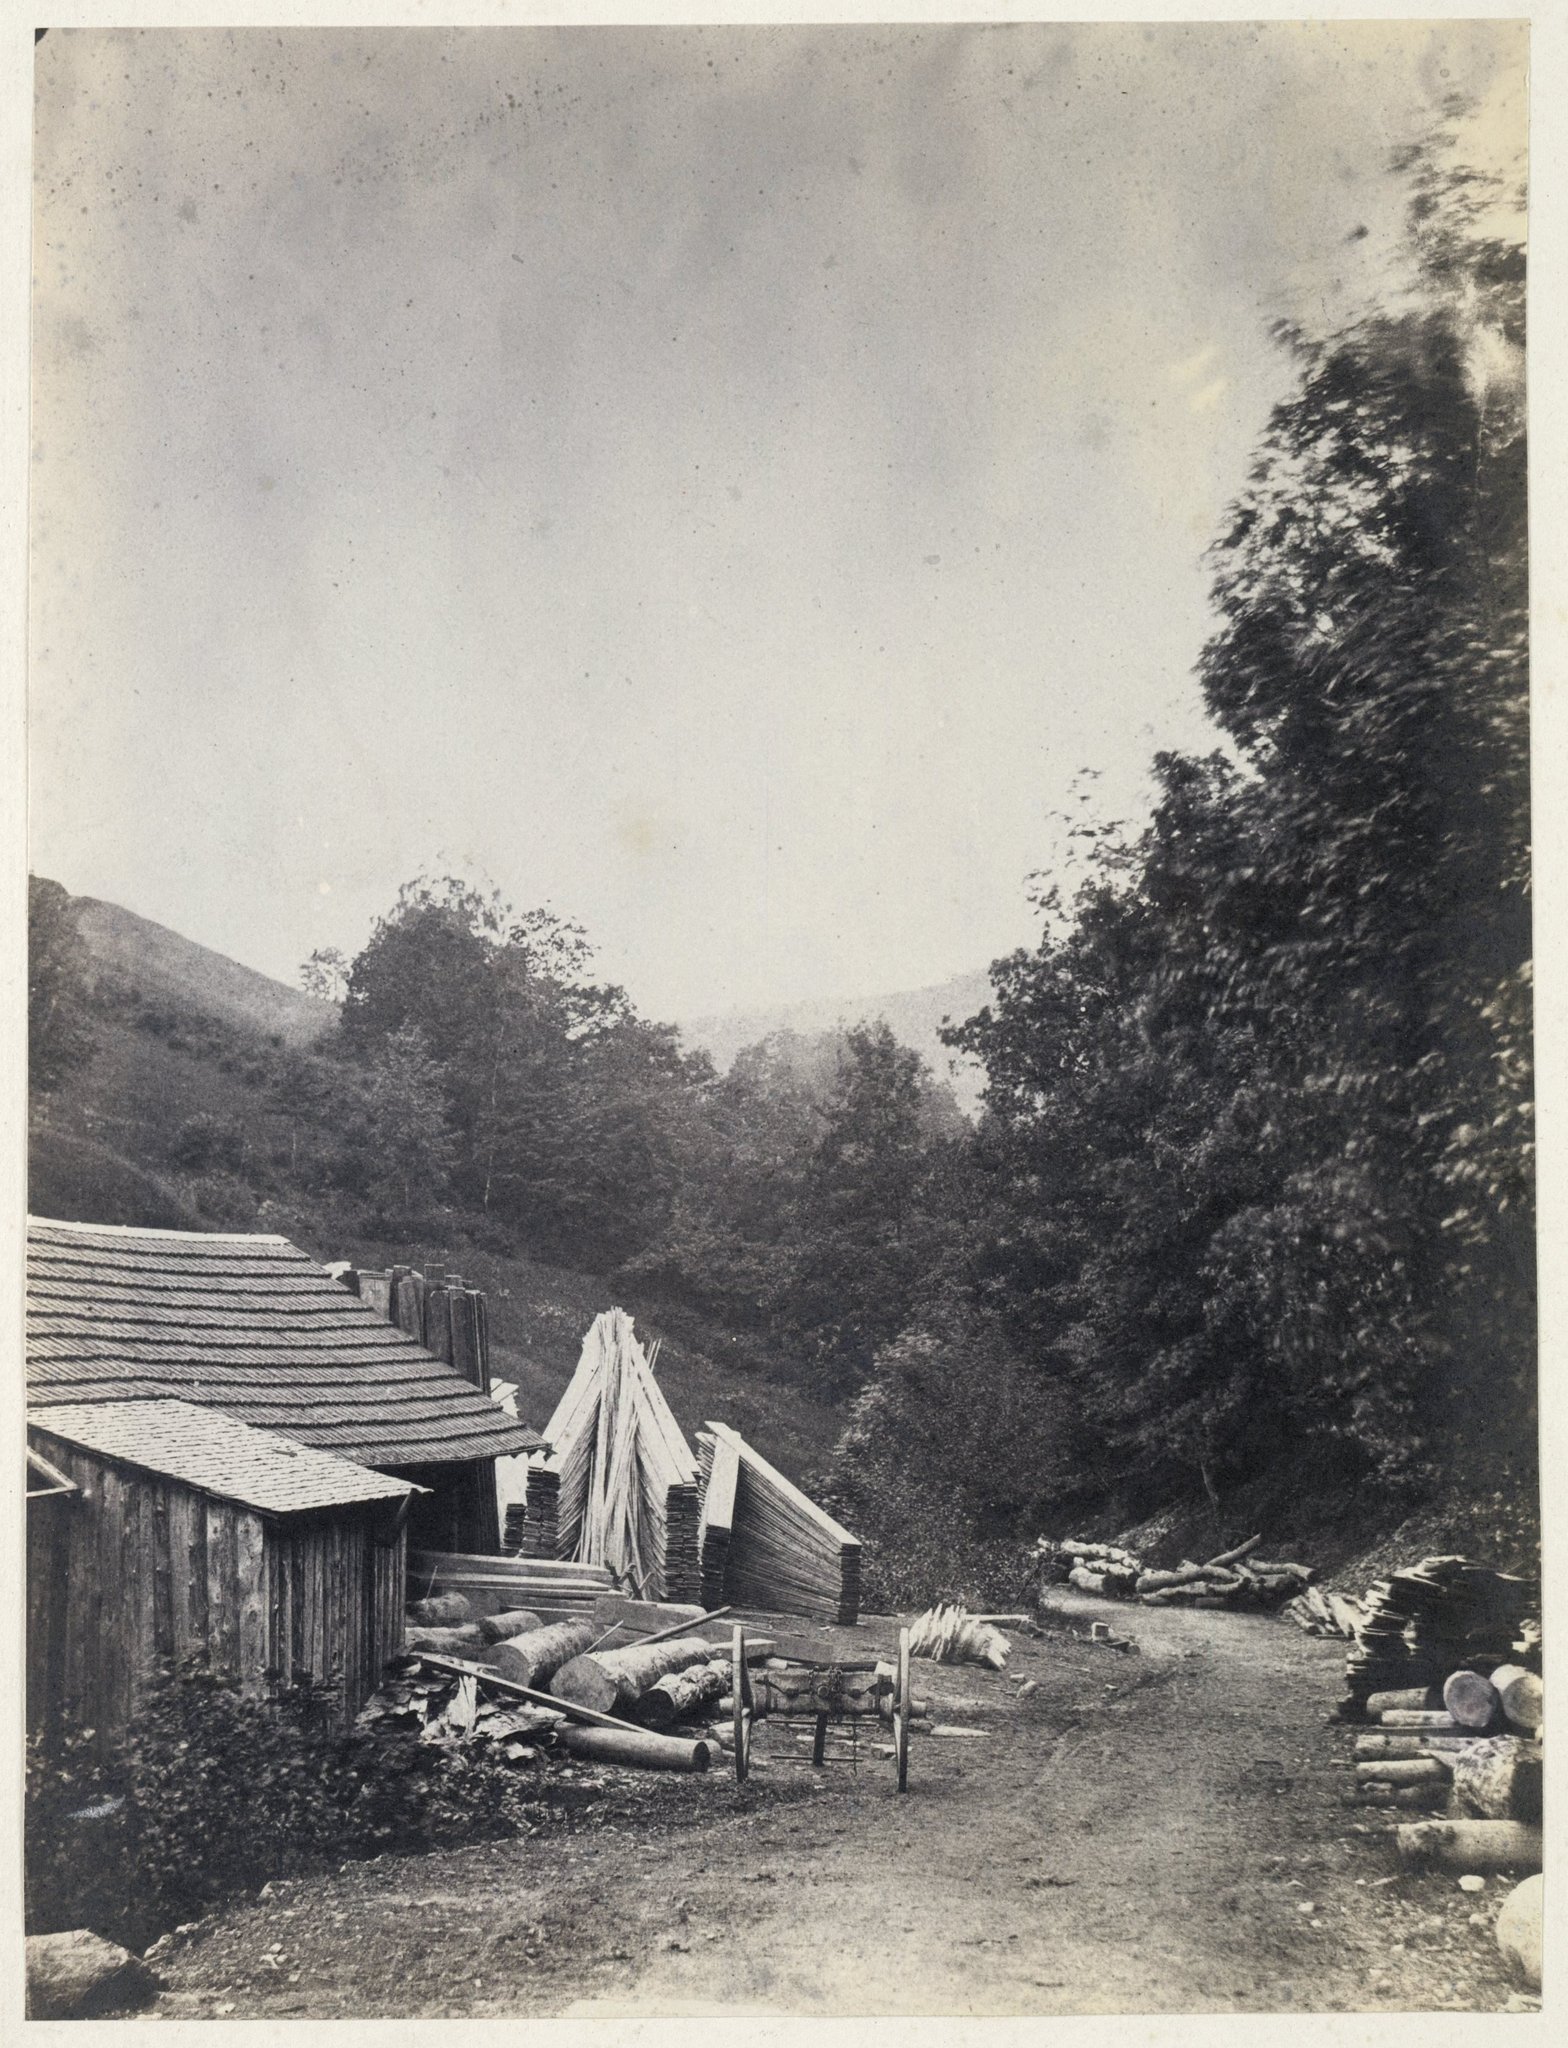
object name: photograph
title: Houtzagerij in heuvellandschap, Frankrijk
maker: Anonymous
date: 1855-1859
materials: cardboard, paper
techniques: salted paper print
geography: france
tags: wood, timber ~ building material, saw-mill (works), france